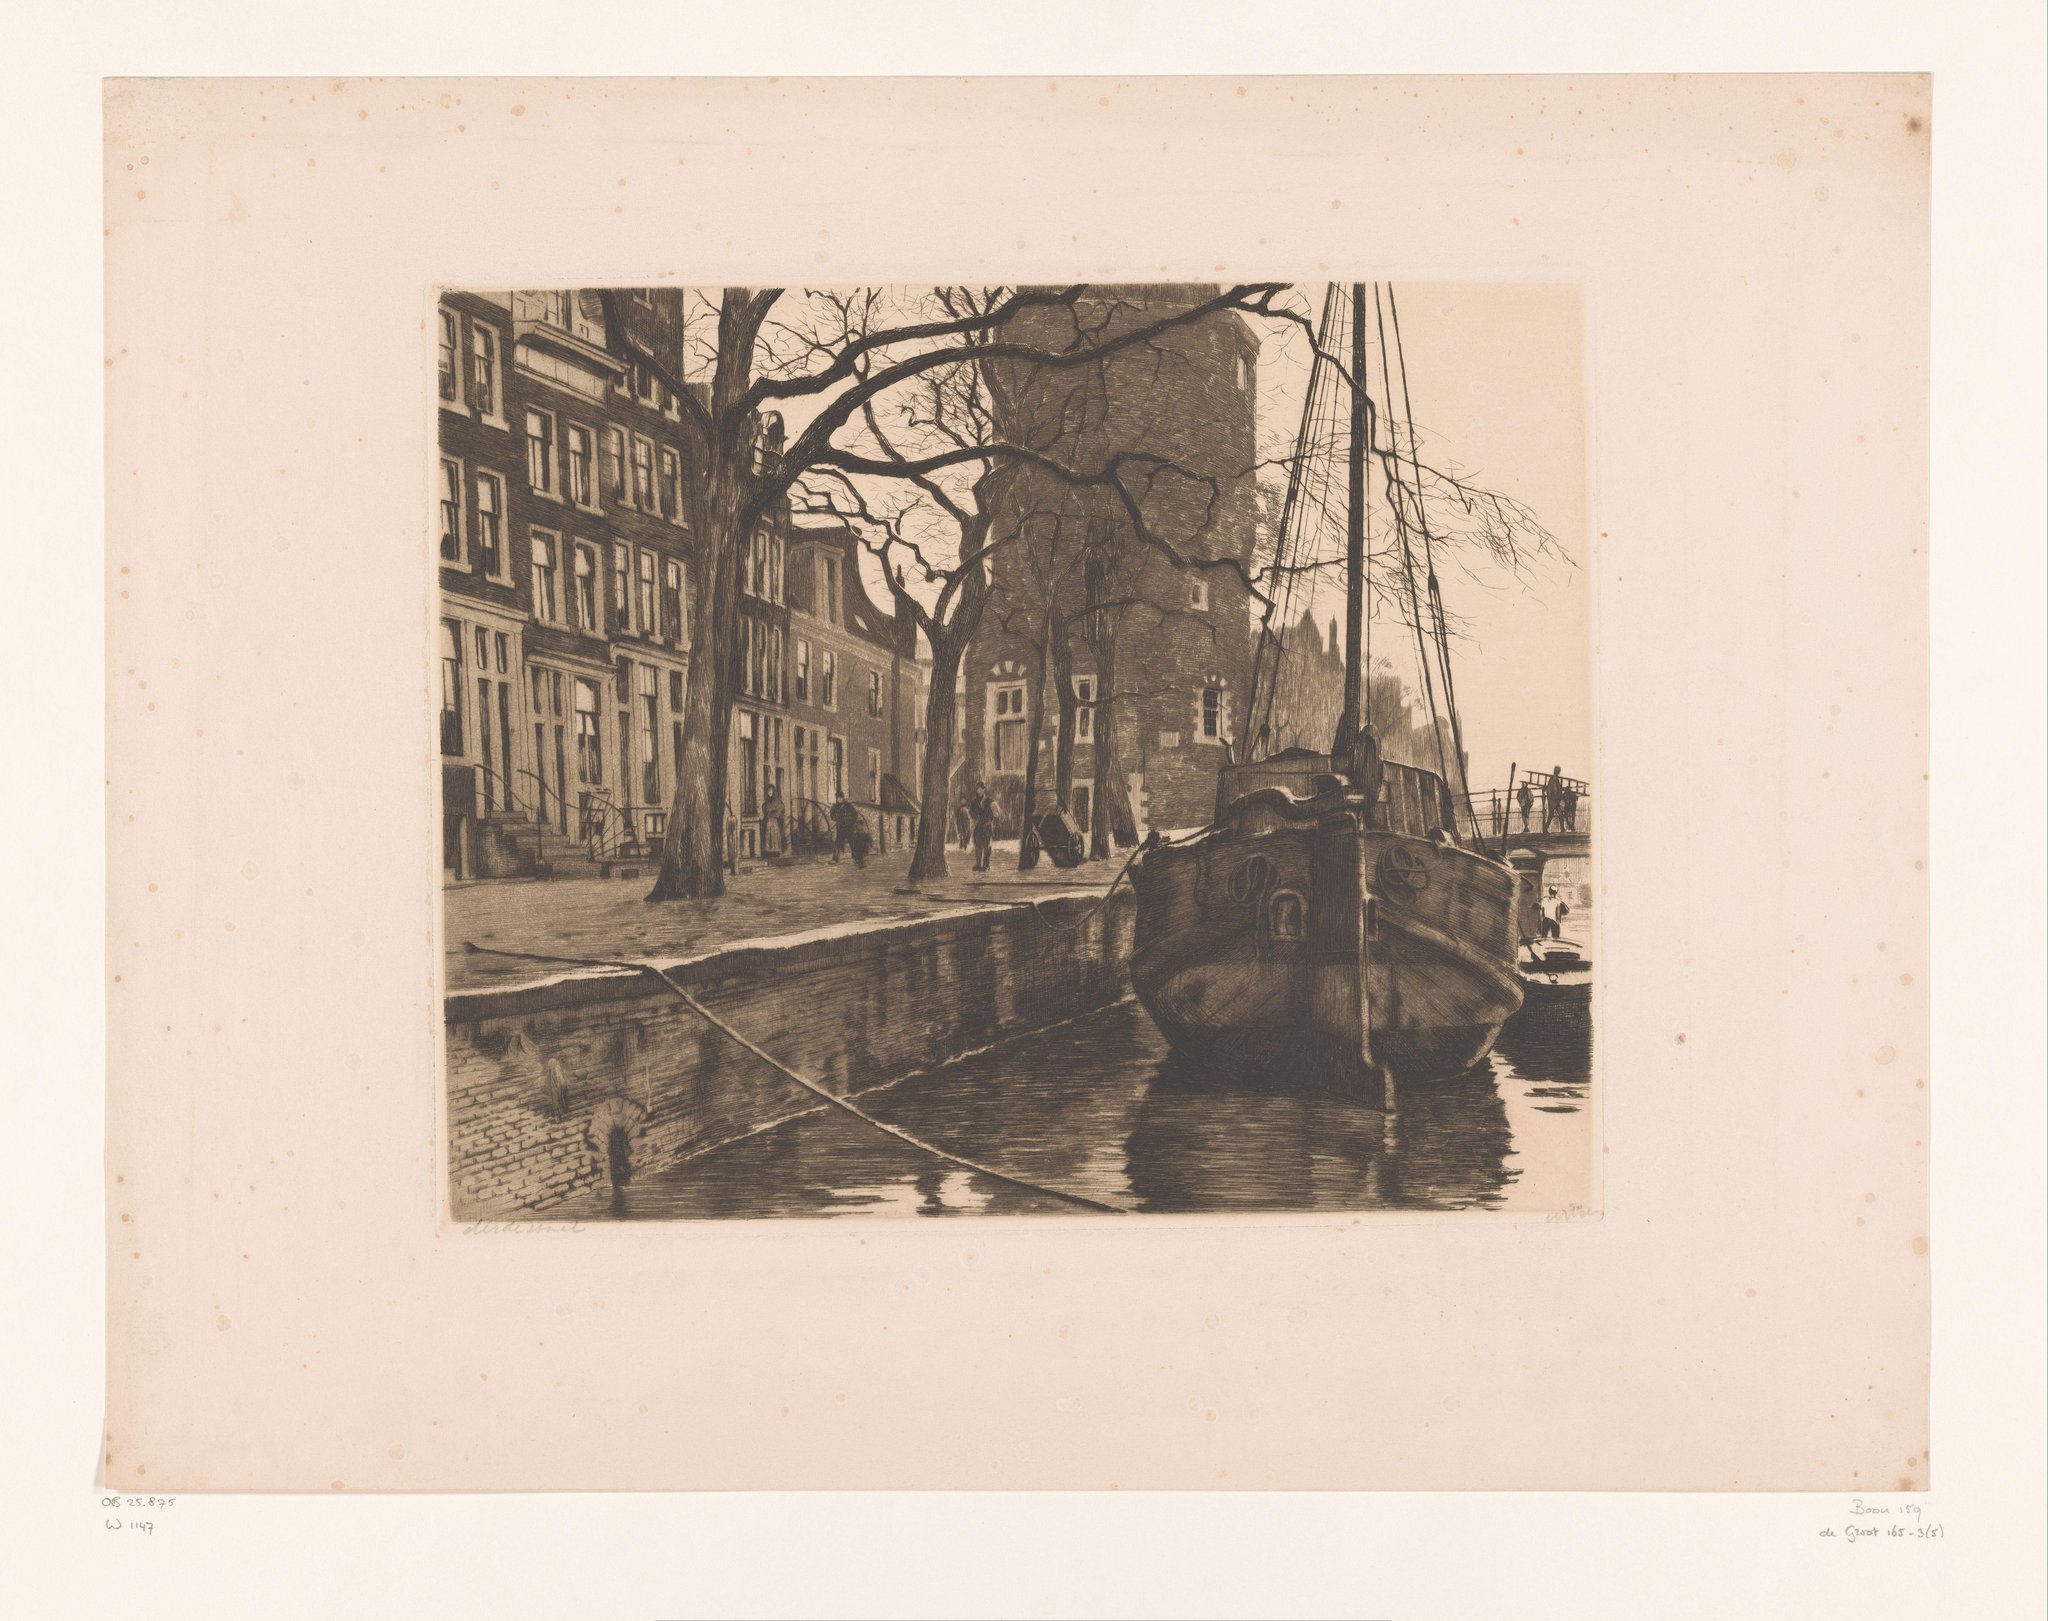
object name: print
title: Gezicht vanaf de Waalseilandsgracht op de Montelbaanstoren en enkele huizen aan de Oude Waal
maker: willem witsen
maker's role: draughtsman, painter, print maker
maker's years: 1860-1923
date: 1912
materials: paper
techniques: aquatint, etching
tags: urban housing, sailing-ship, sailing-boat, bridge in city across river, canal, etc., tower (of house or building)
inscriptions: annotation: ‘derde staat’